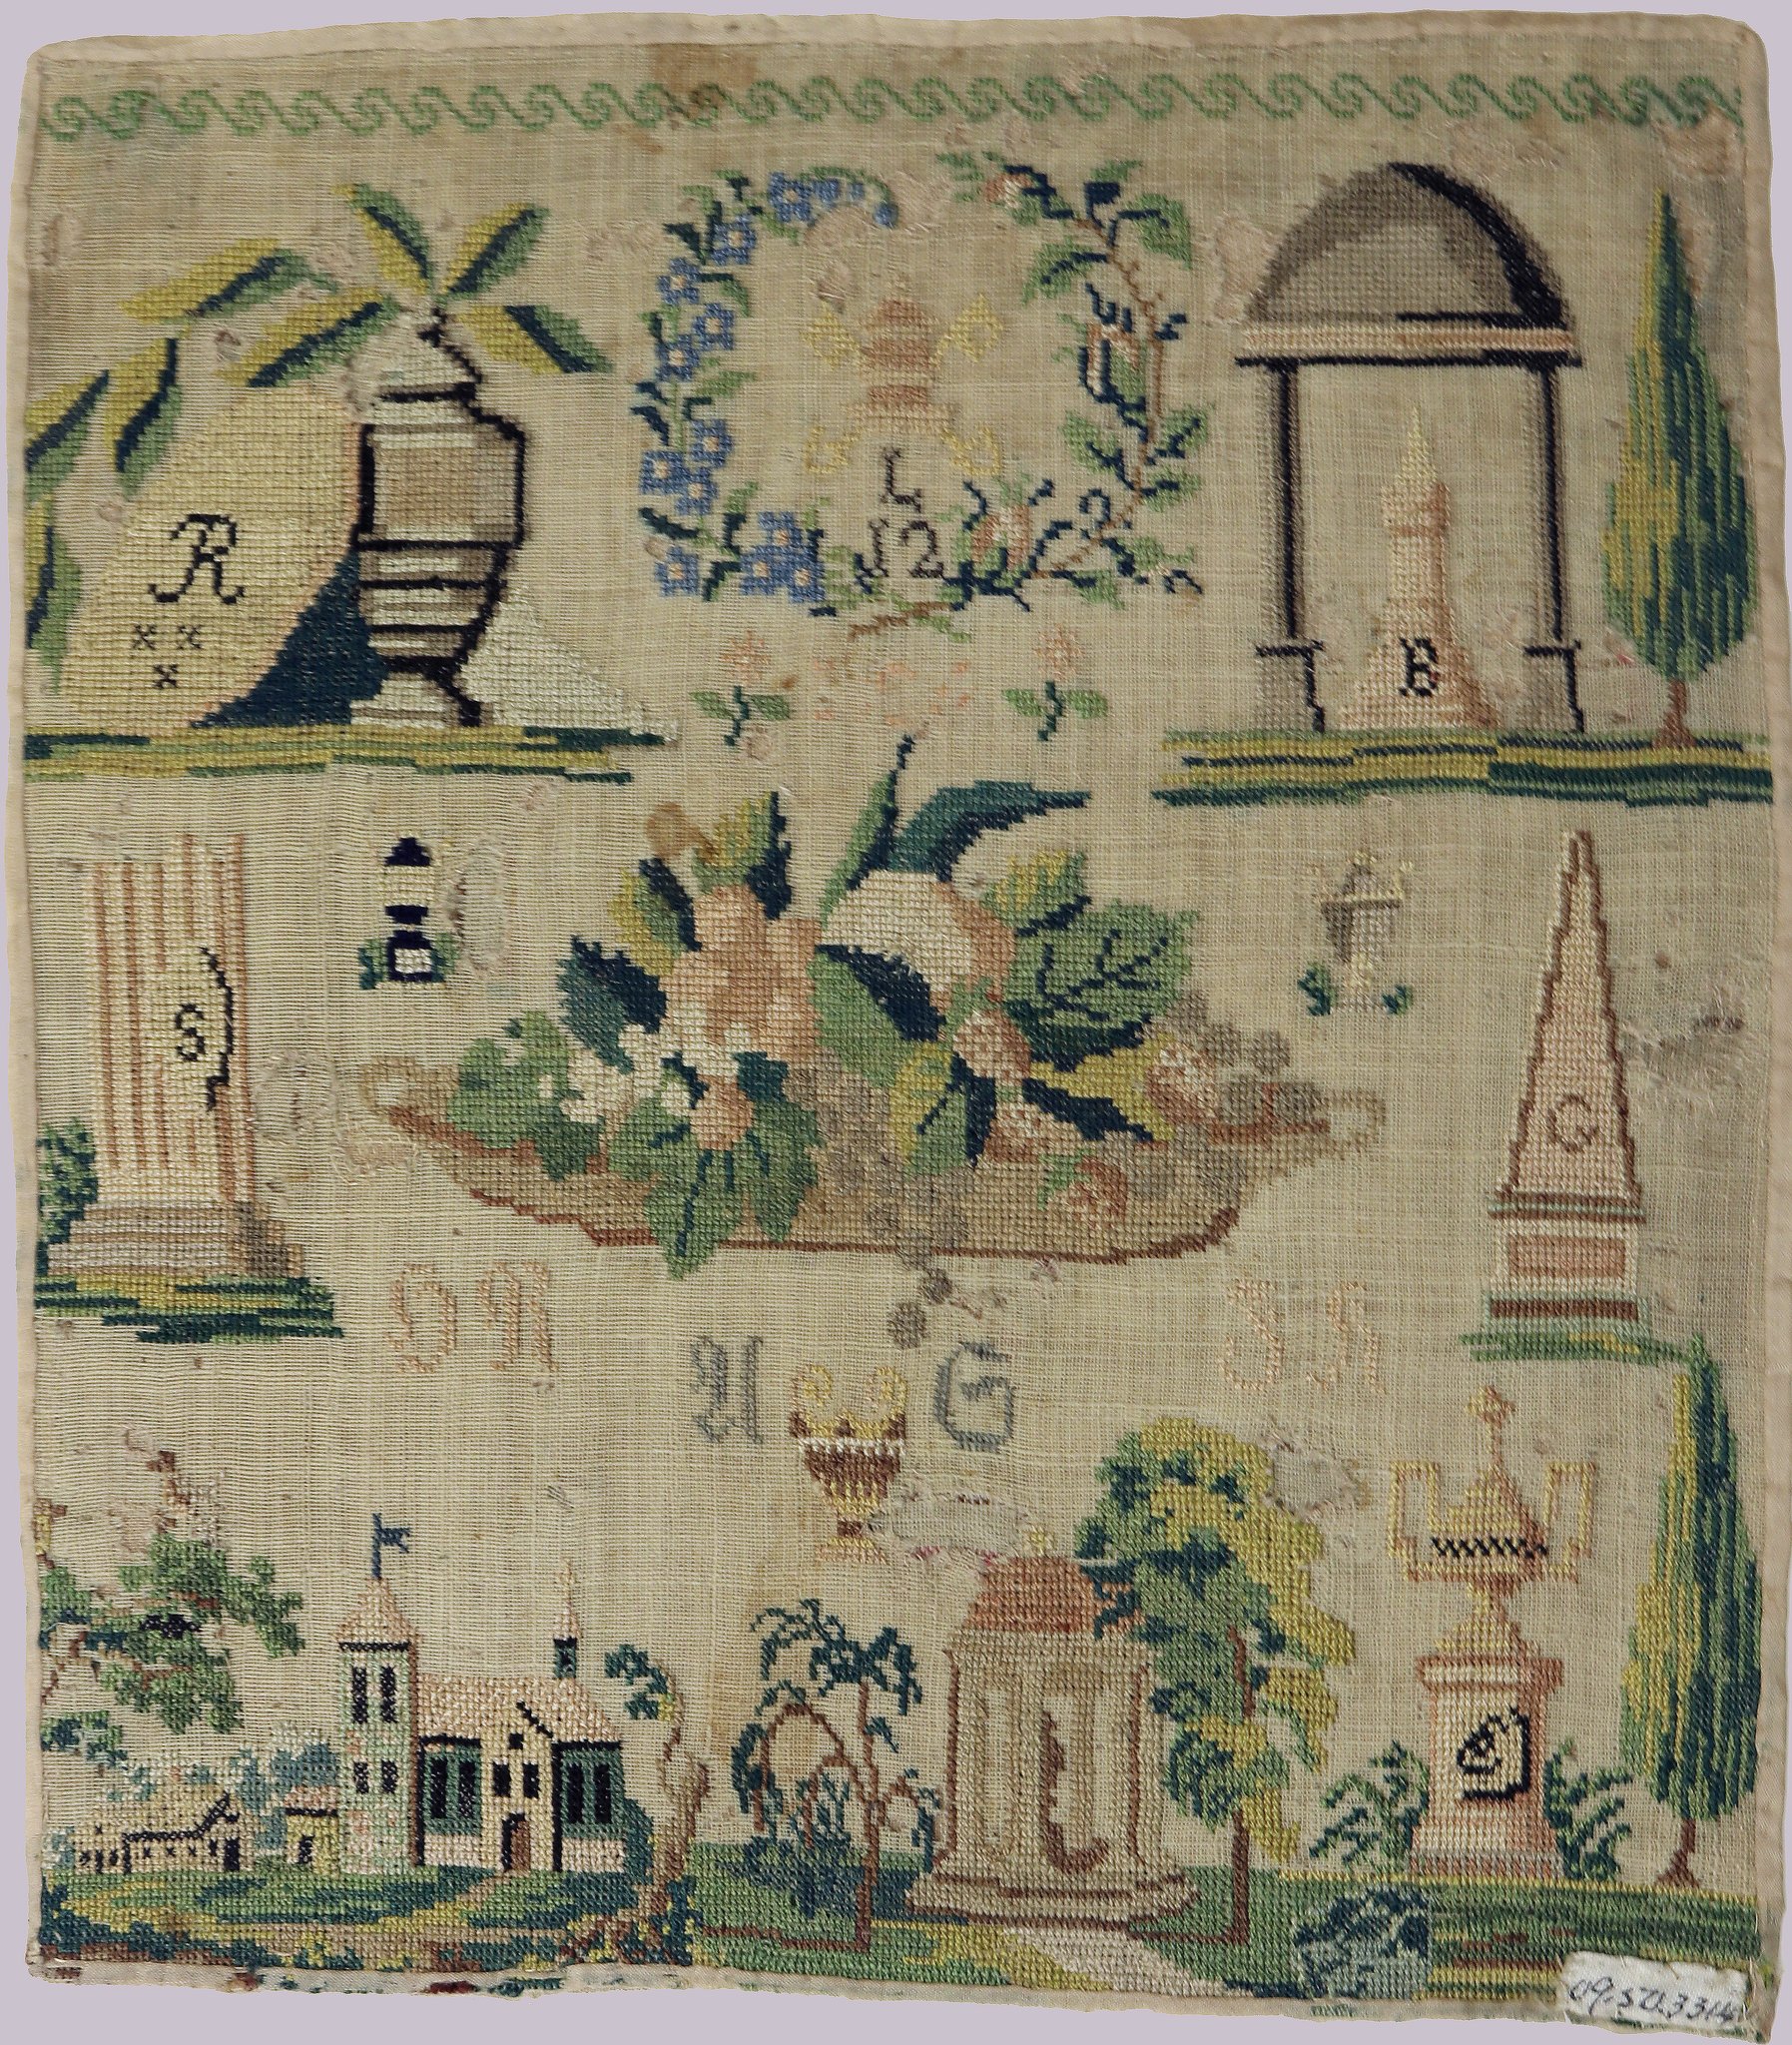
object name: sampler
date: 1825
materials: canvas, linen, silk